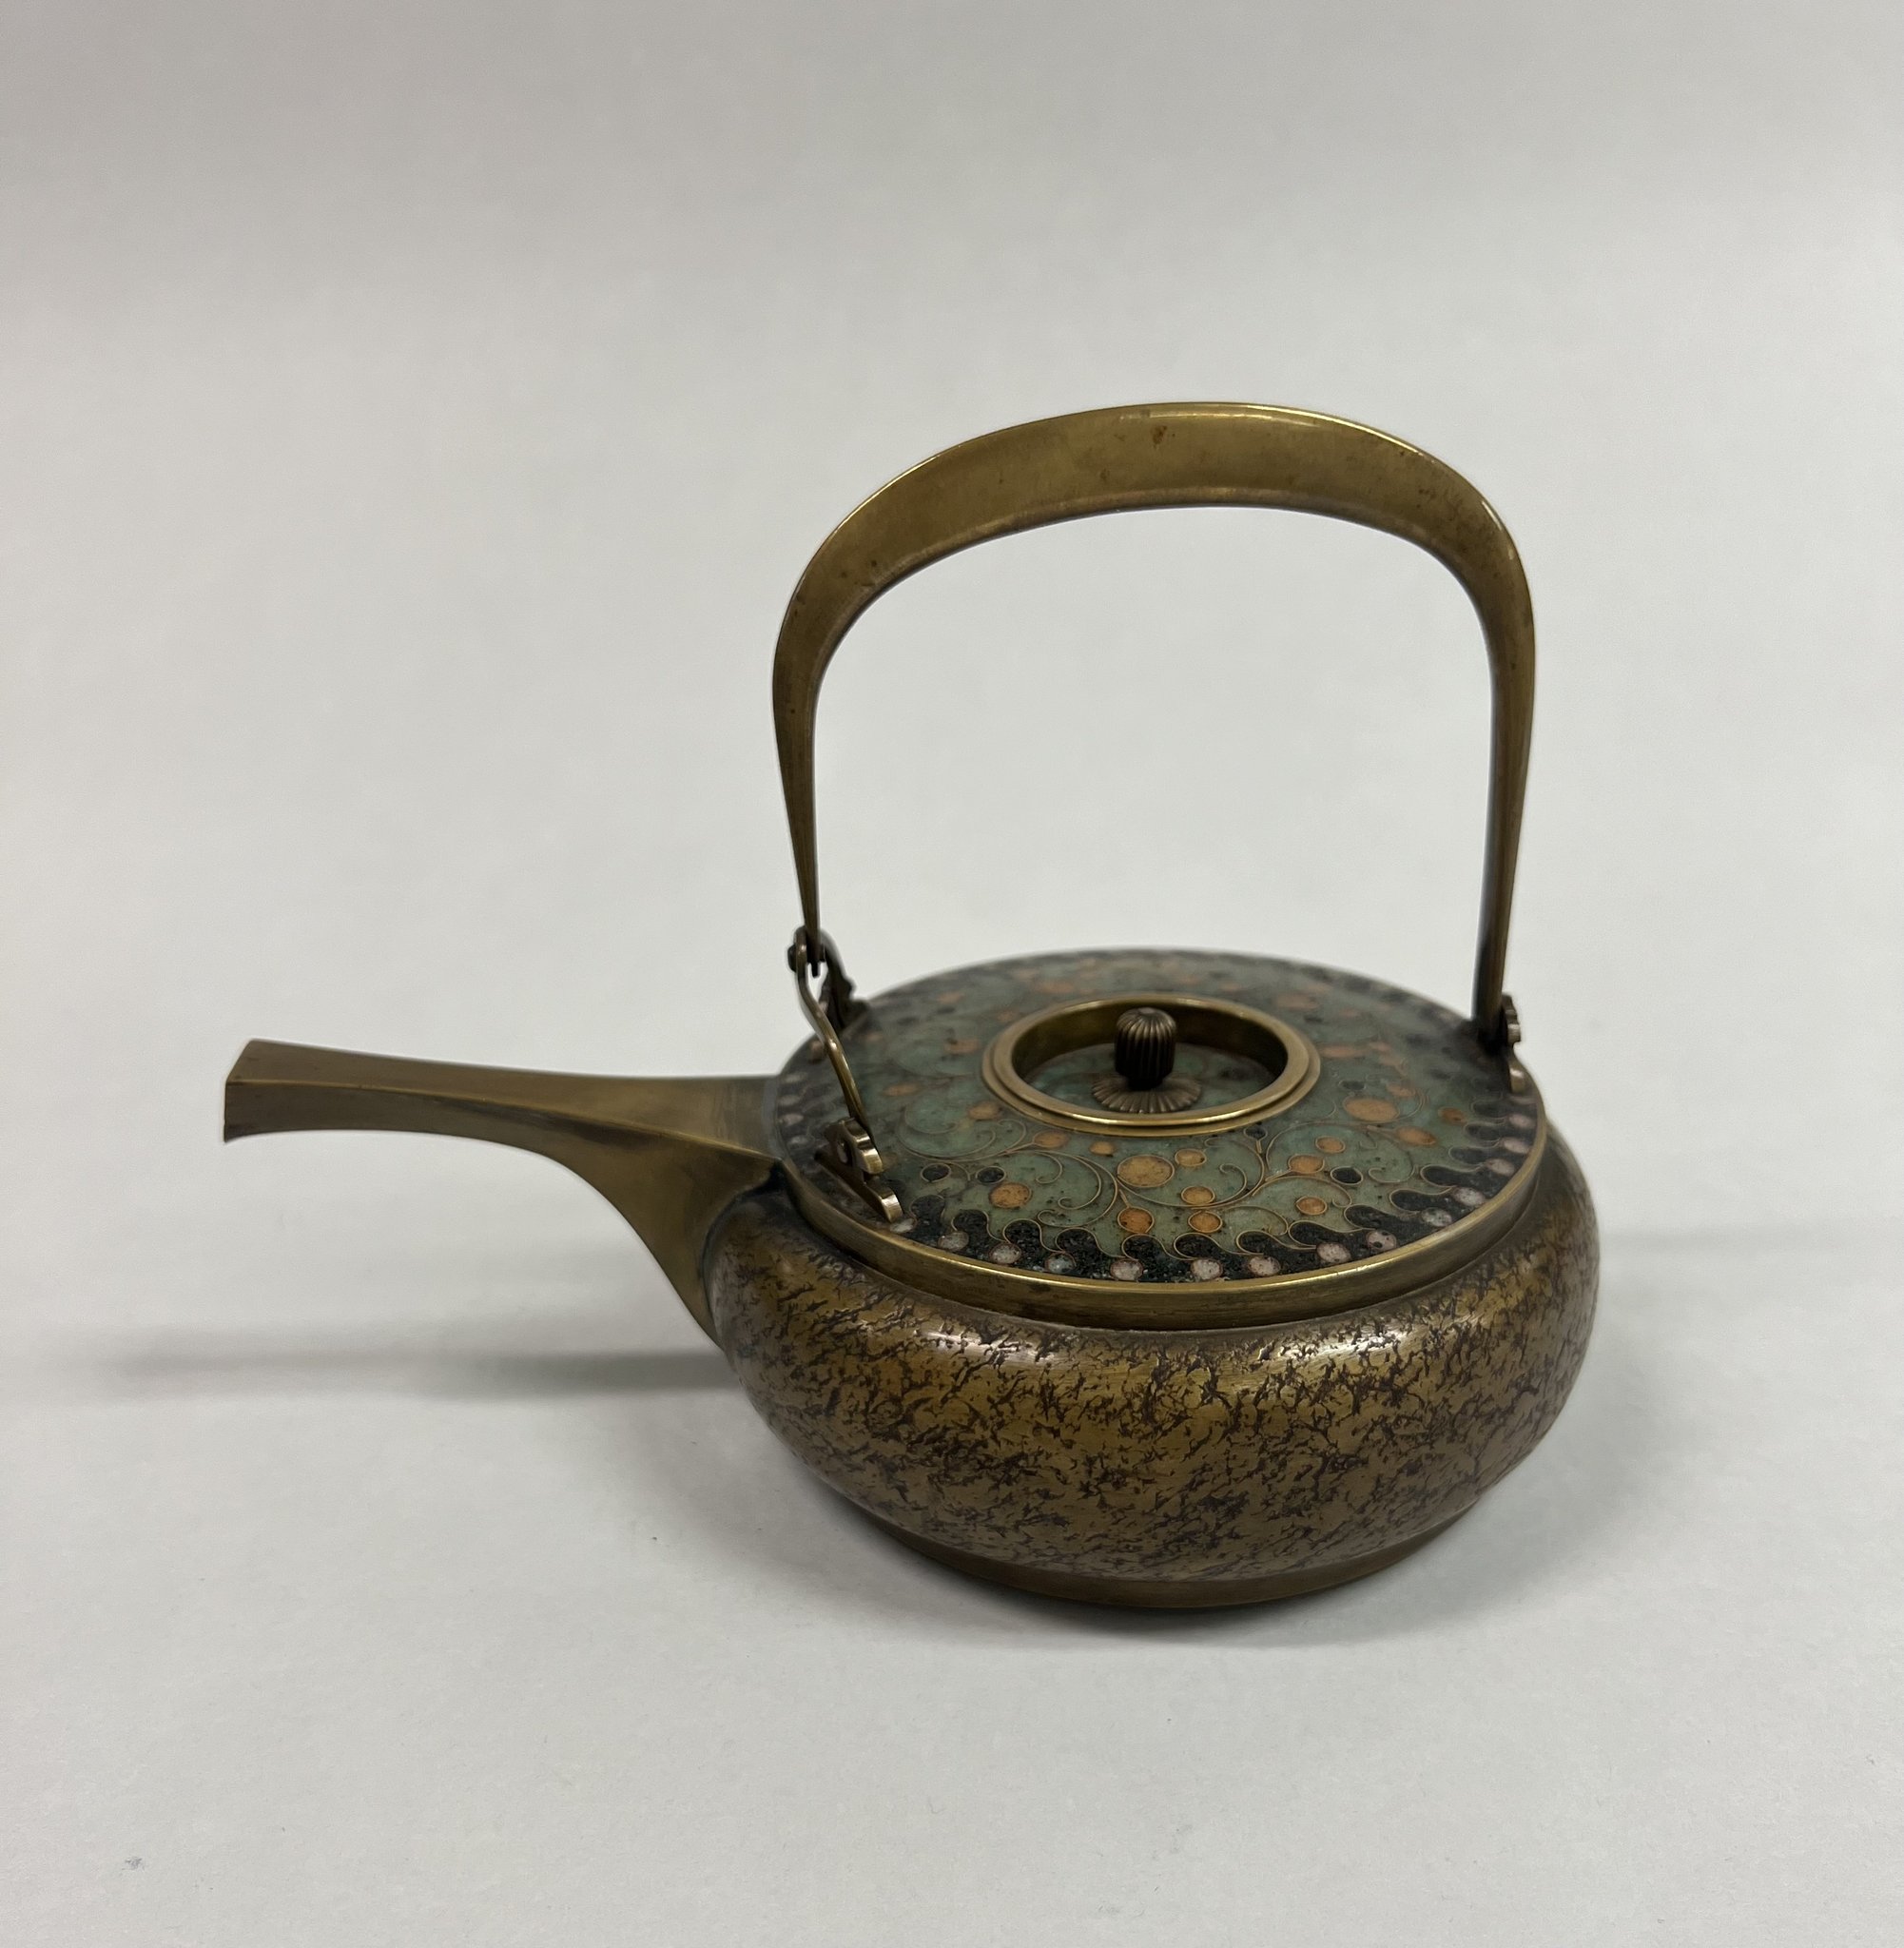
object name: pot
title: Pot for Wine or Tea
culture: japanese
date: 1801-1900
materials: bronze